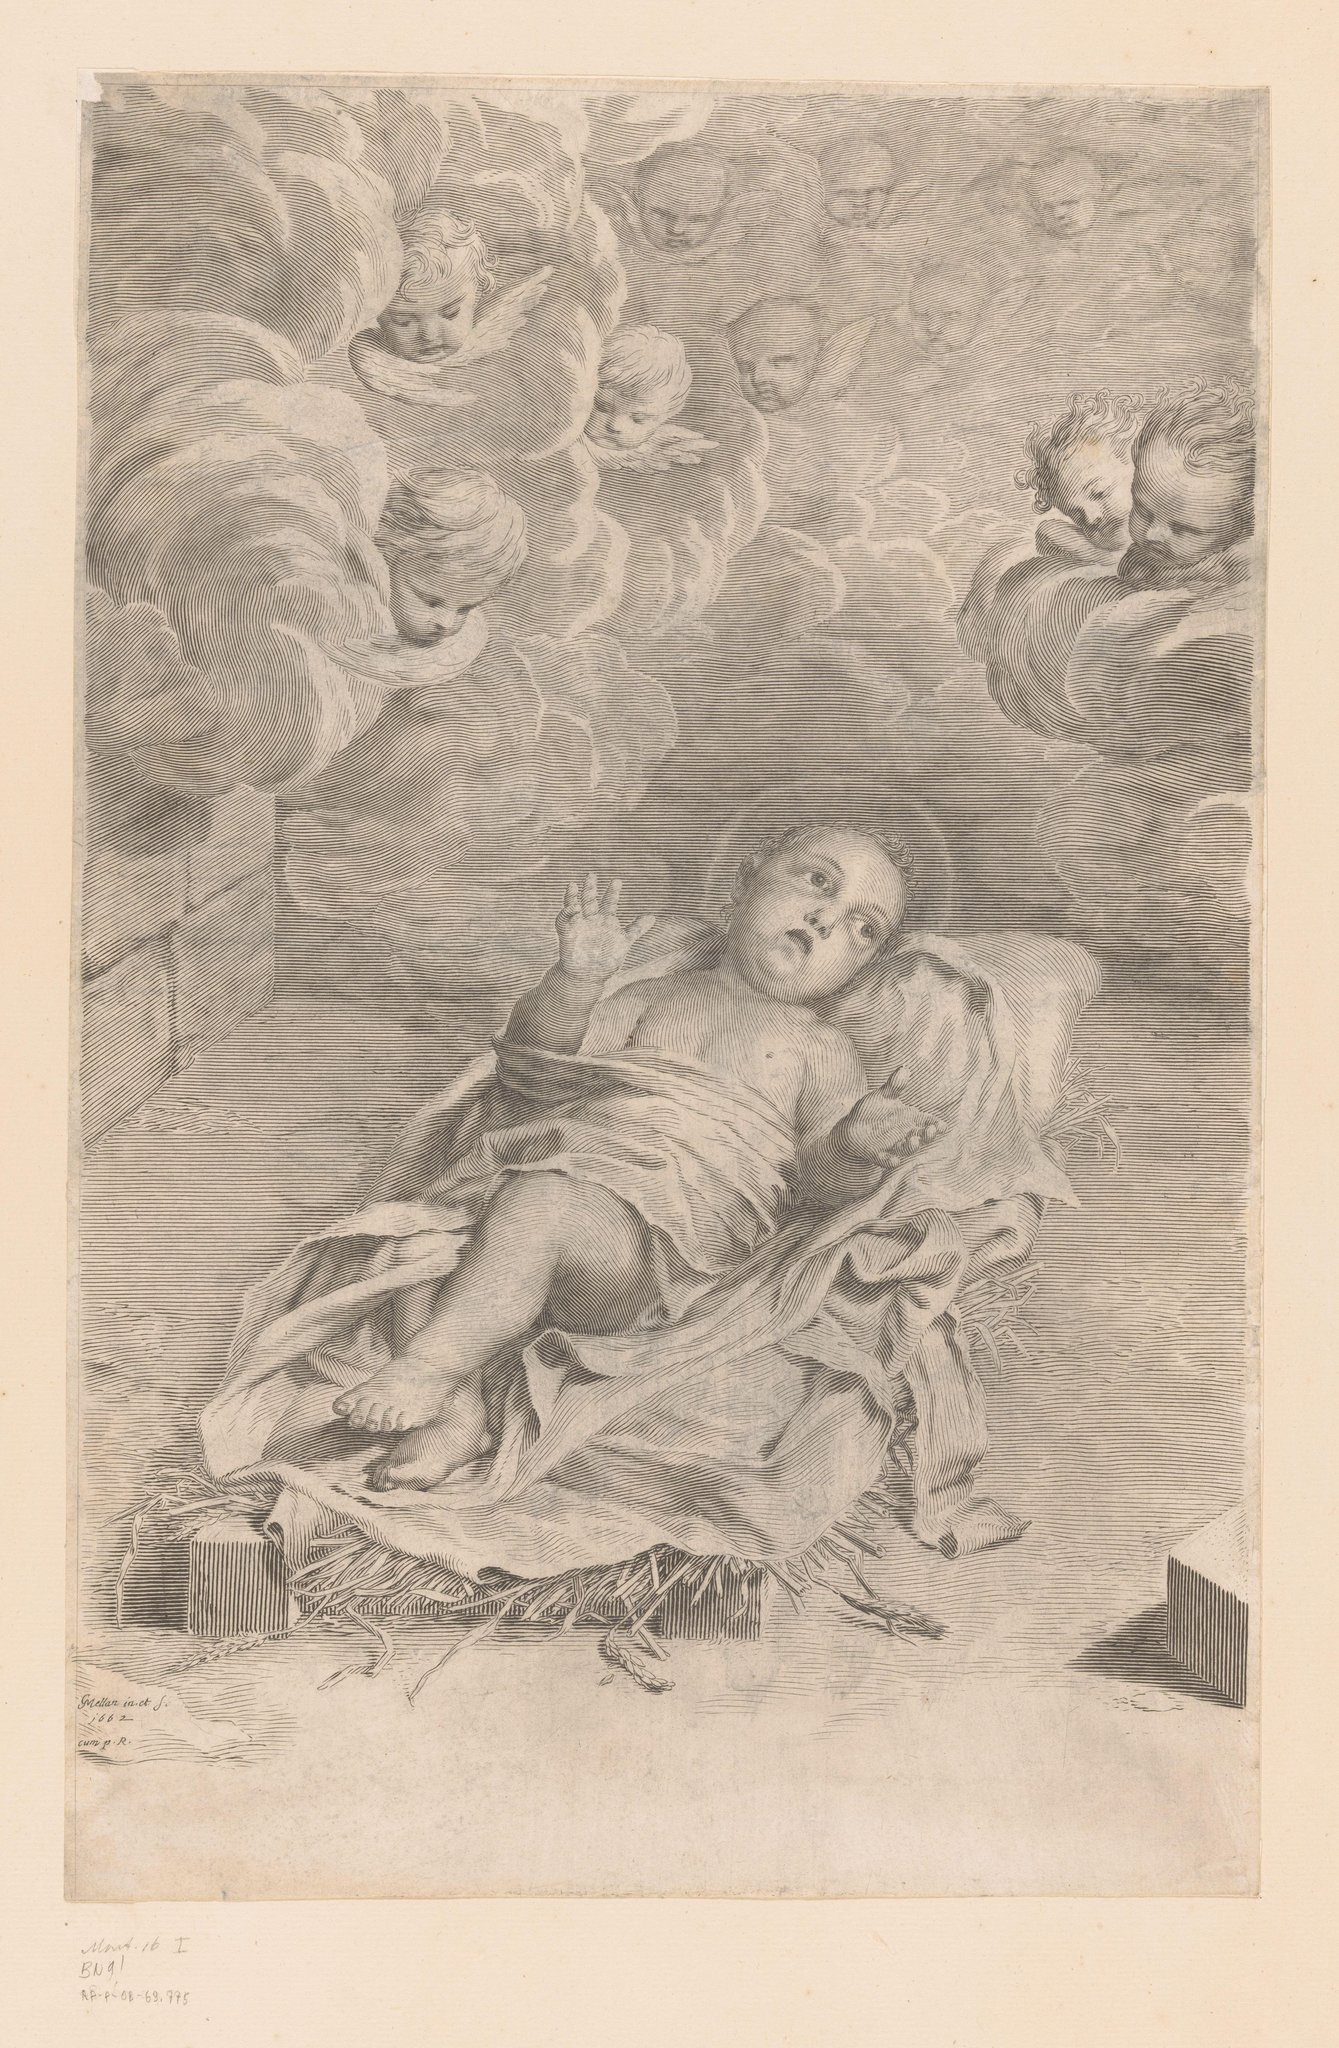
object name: print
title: Christuskind in de kribbe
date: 1662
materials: paper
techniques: engraving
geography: france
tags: christ-child in the manger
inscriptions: collector's mark: Lugt 240